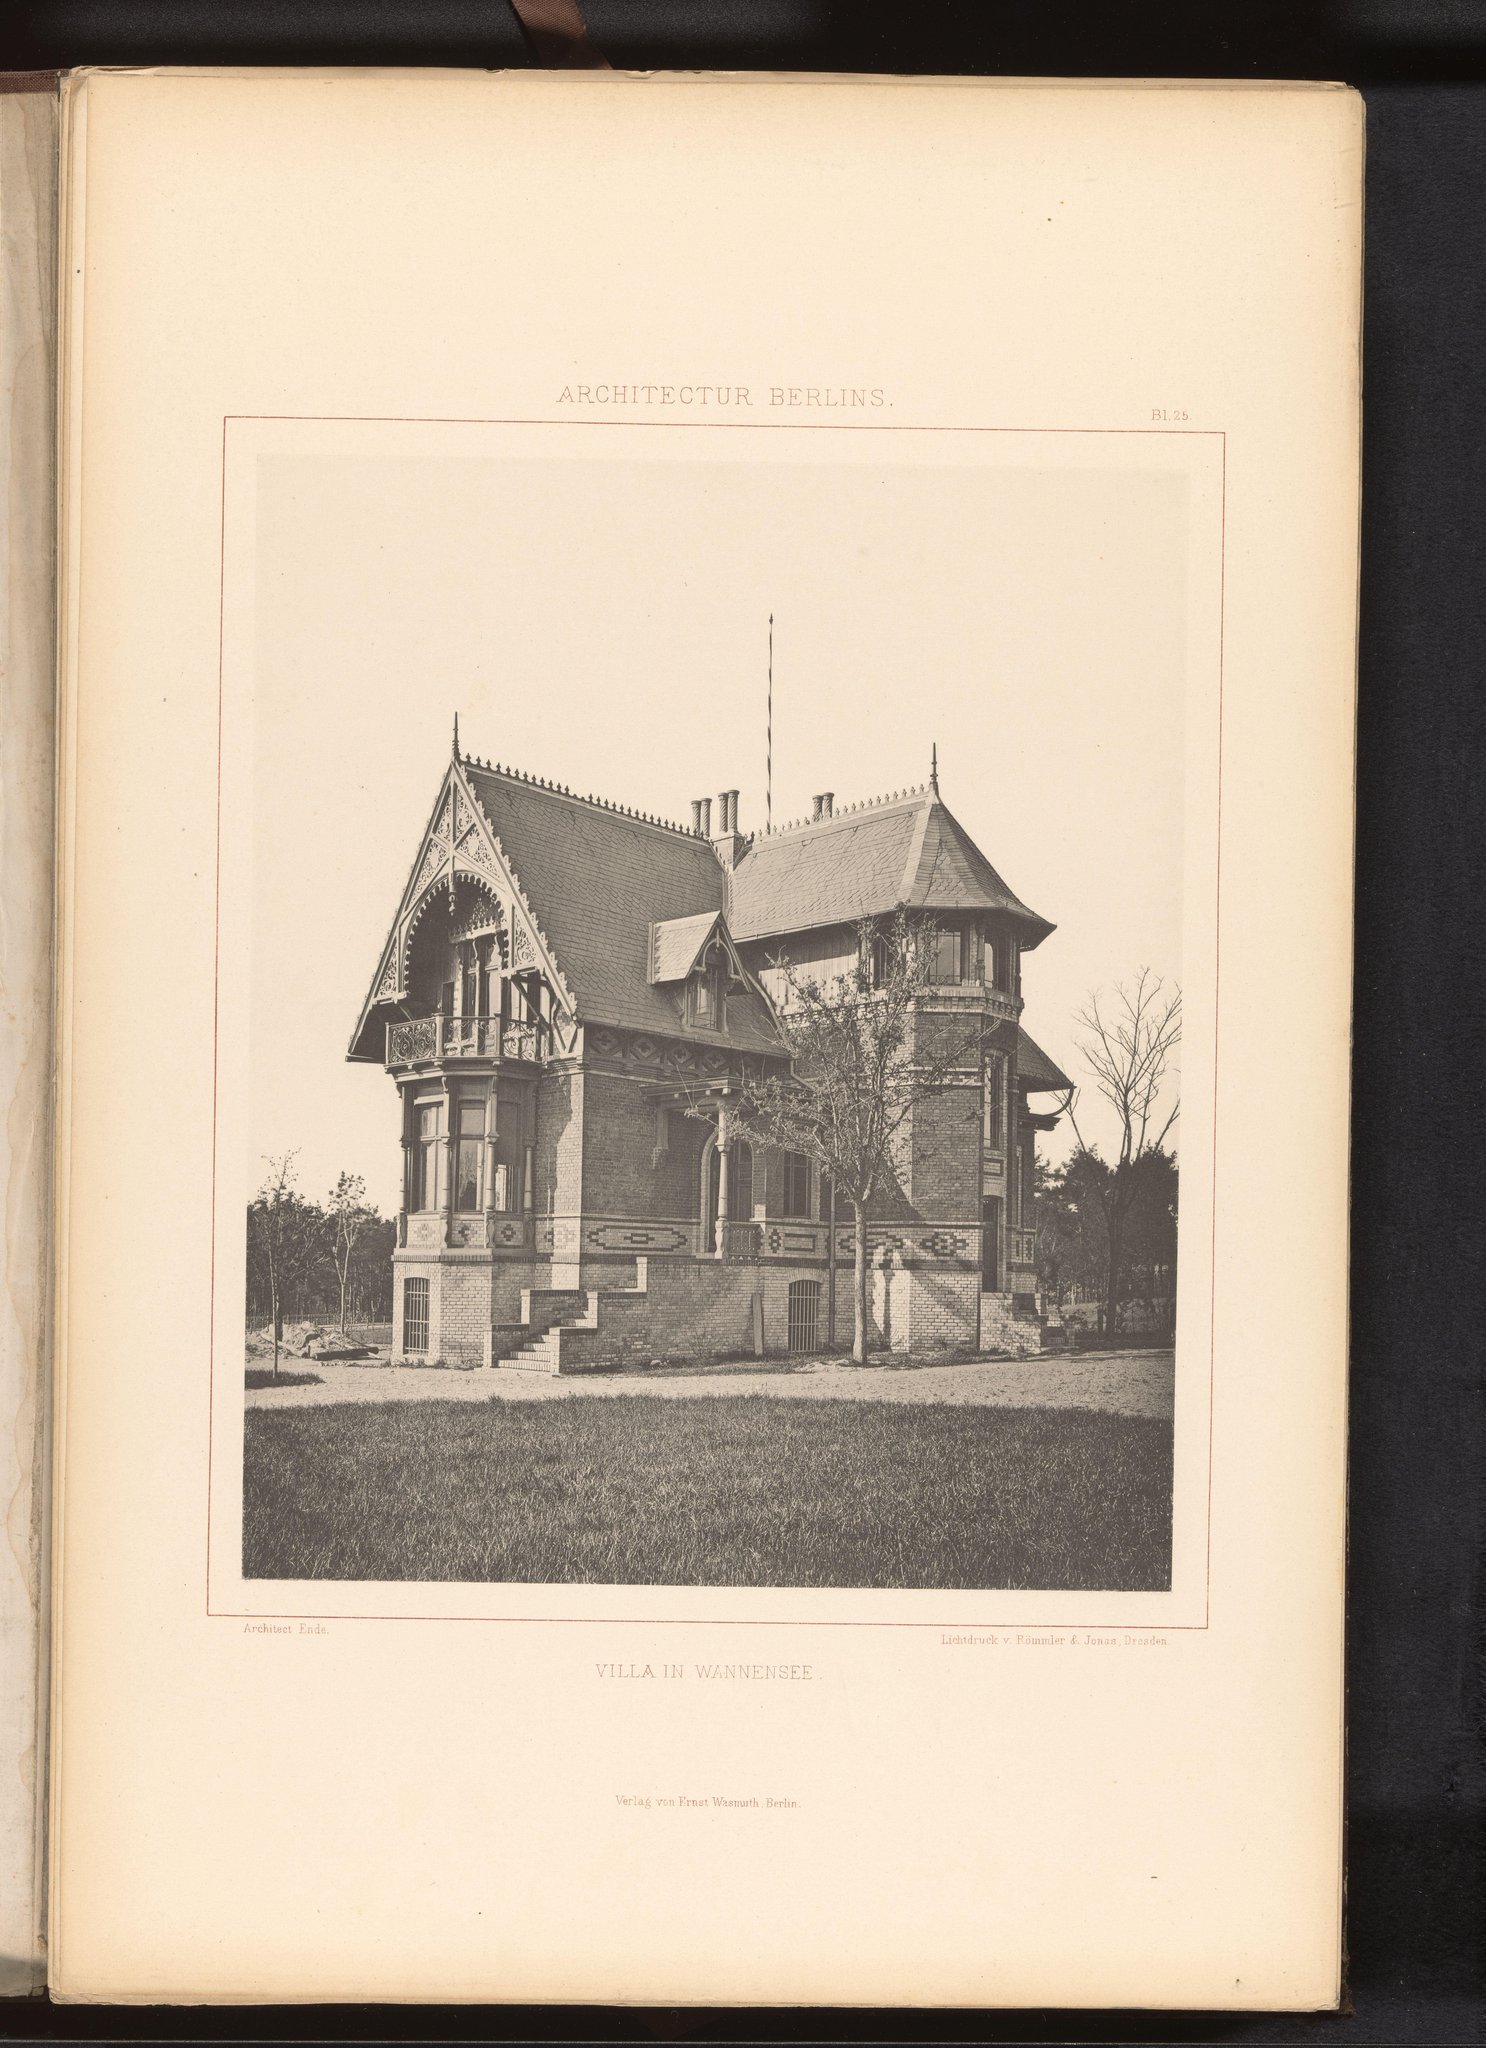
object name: photomechanical print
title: Architectur Berlins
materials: paper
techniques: photograph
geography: berlin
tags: detached house in city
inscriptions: inscription: ‘Architect Ende.’, number: ‘Bl. 25.’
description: Deze prent maakt deel uit van een omslag met honderd prenten en zes tekstbladen.